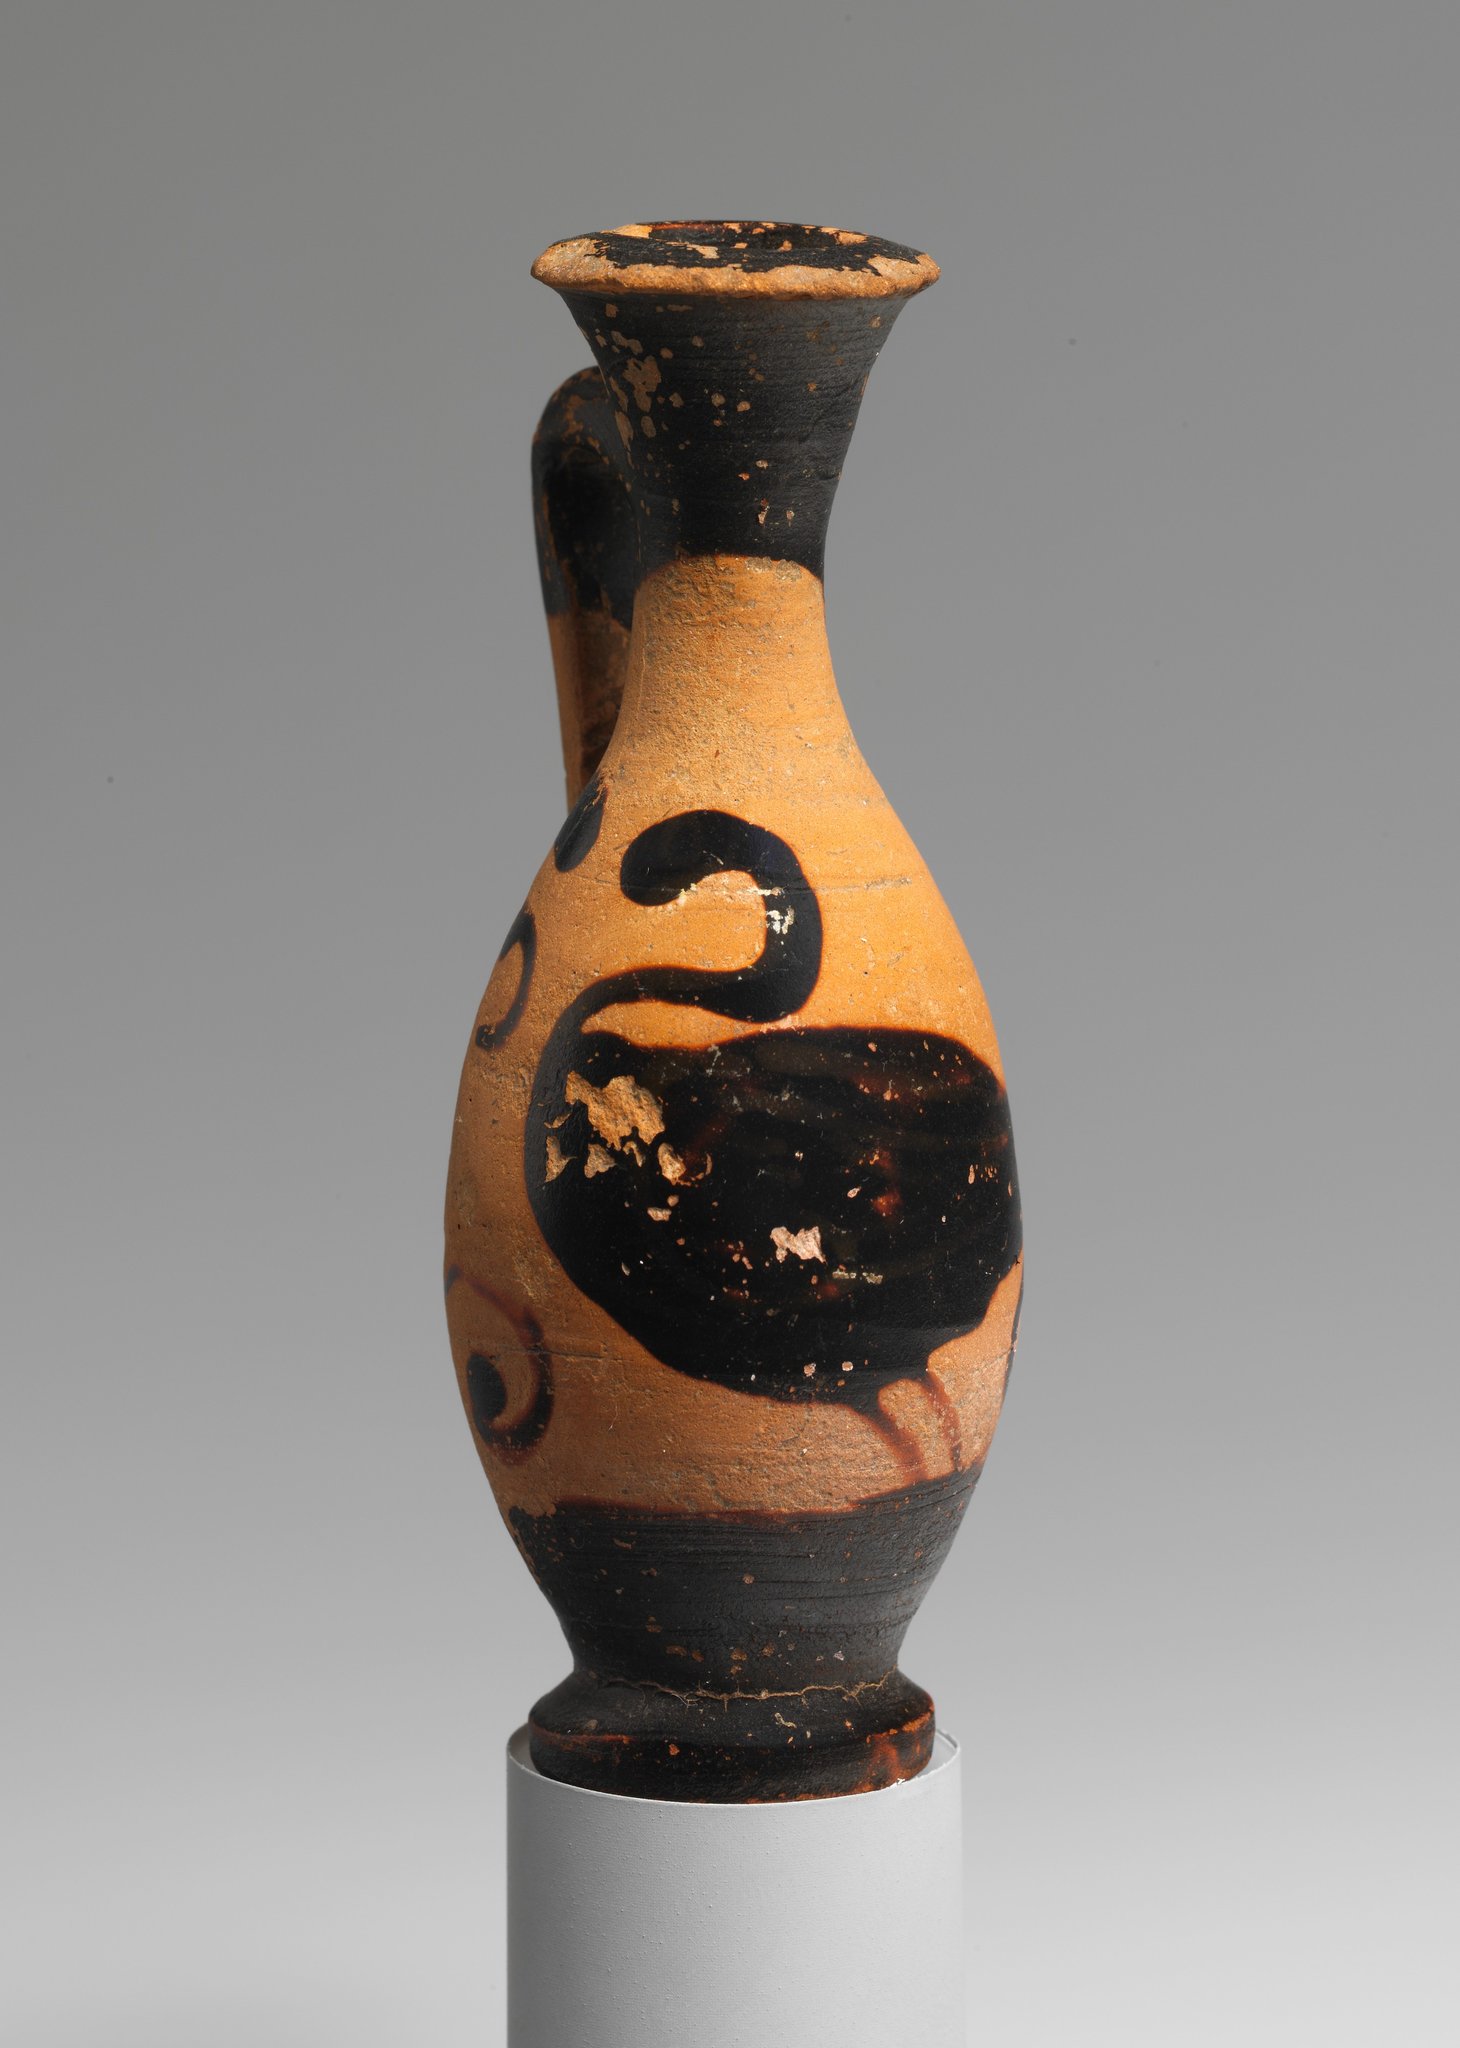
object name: lekythos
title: Terracotta toy lekythos (oil flask) with a swan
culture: greek or south italian or campanian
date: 400-301 BCE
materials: terracotta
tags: swans